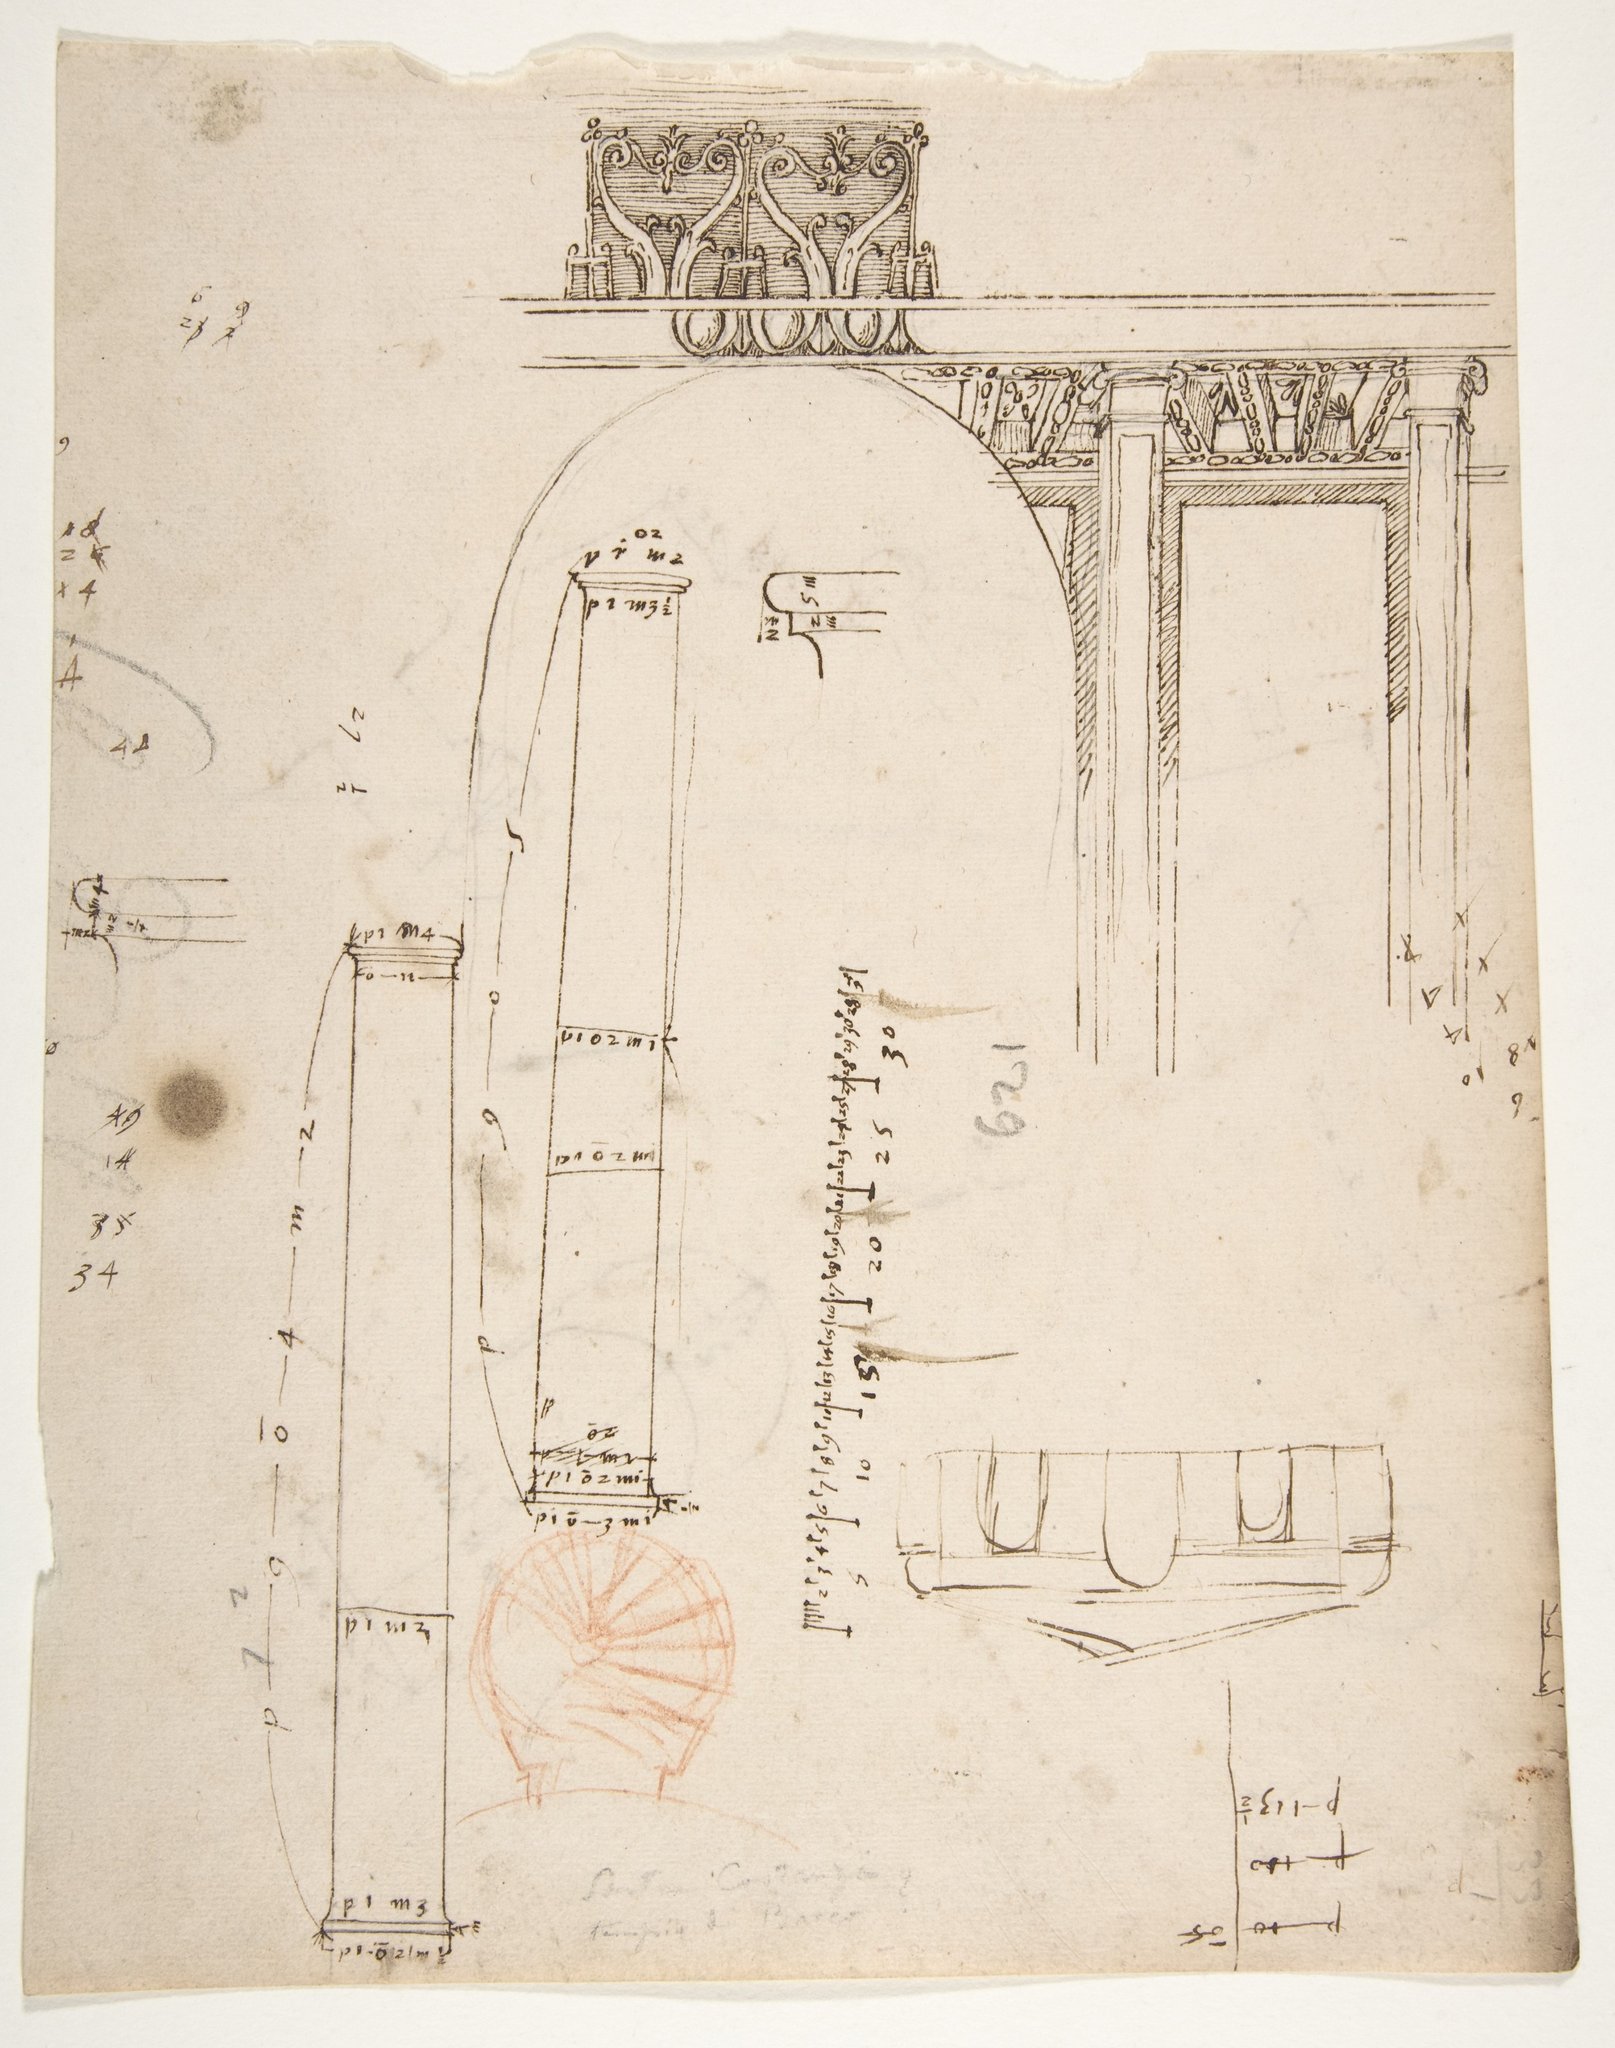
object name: collection ornament architecture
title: S. Costanza, drum, interior, elevation; column shafts, profiles; narthex, section; stair, detail plan (recto) stair, plans; window, elevation (verso)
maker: anonymous, french, 16th century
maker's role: draftsman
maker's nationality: french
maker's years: 1500-1600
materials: chalk, ink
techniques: incising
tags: architecture,columns